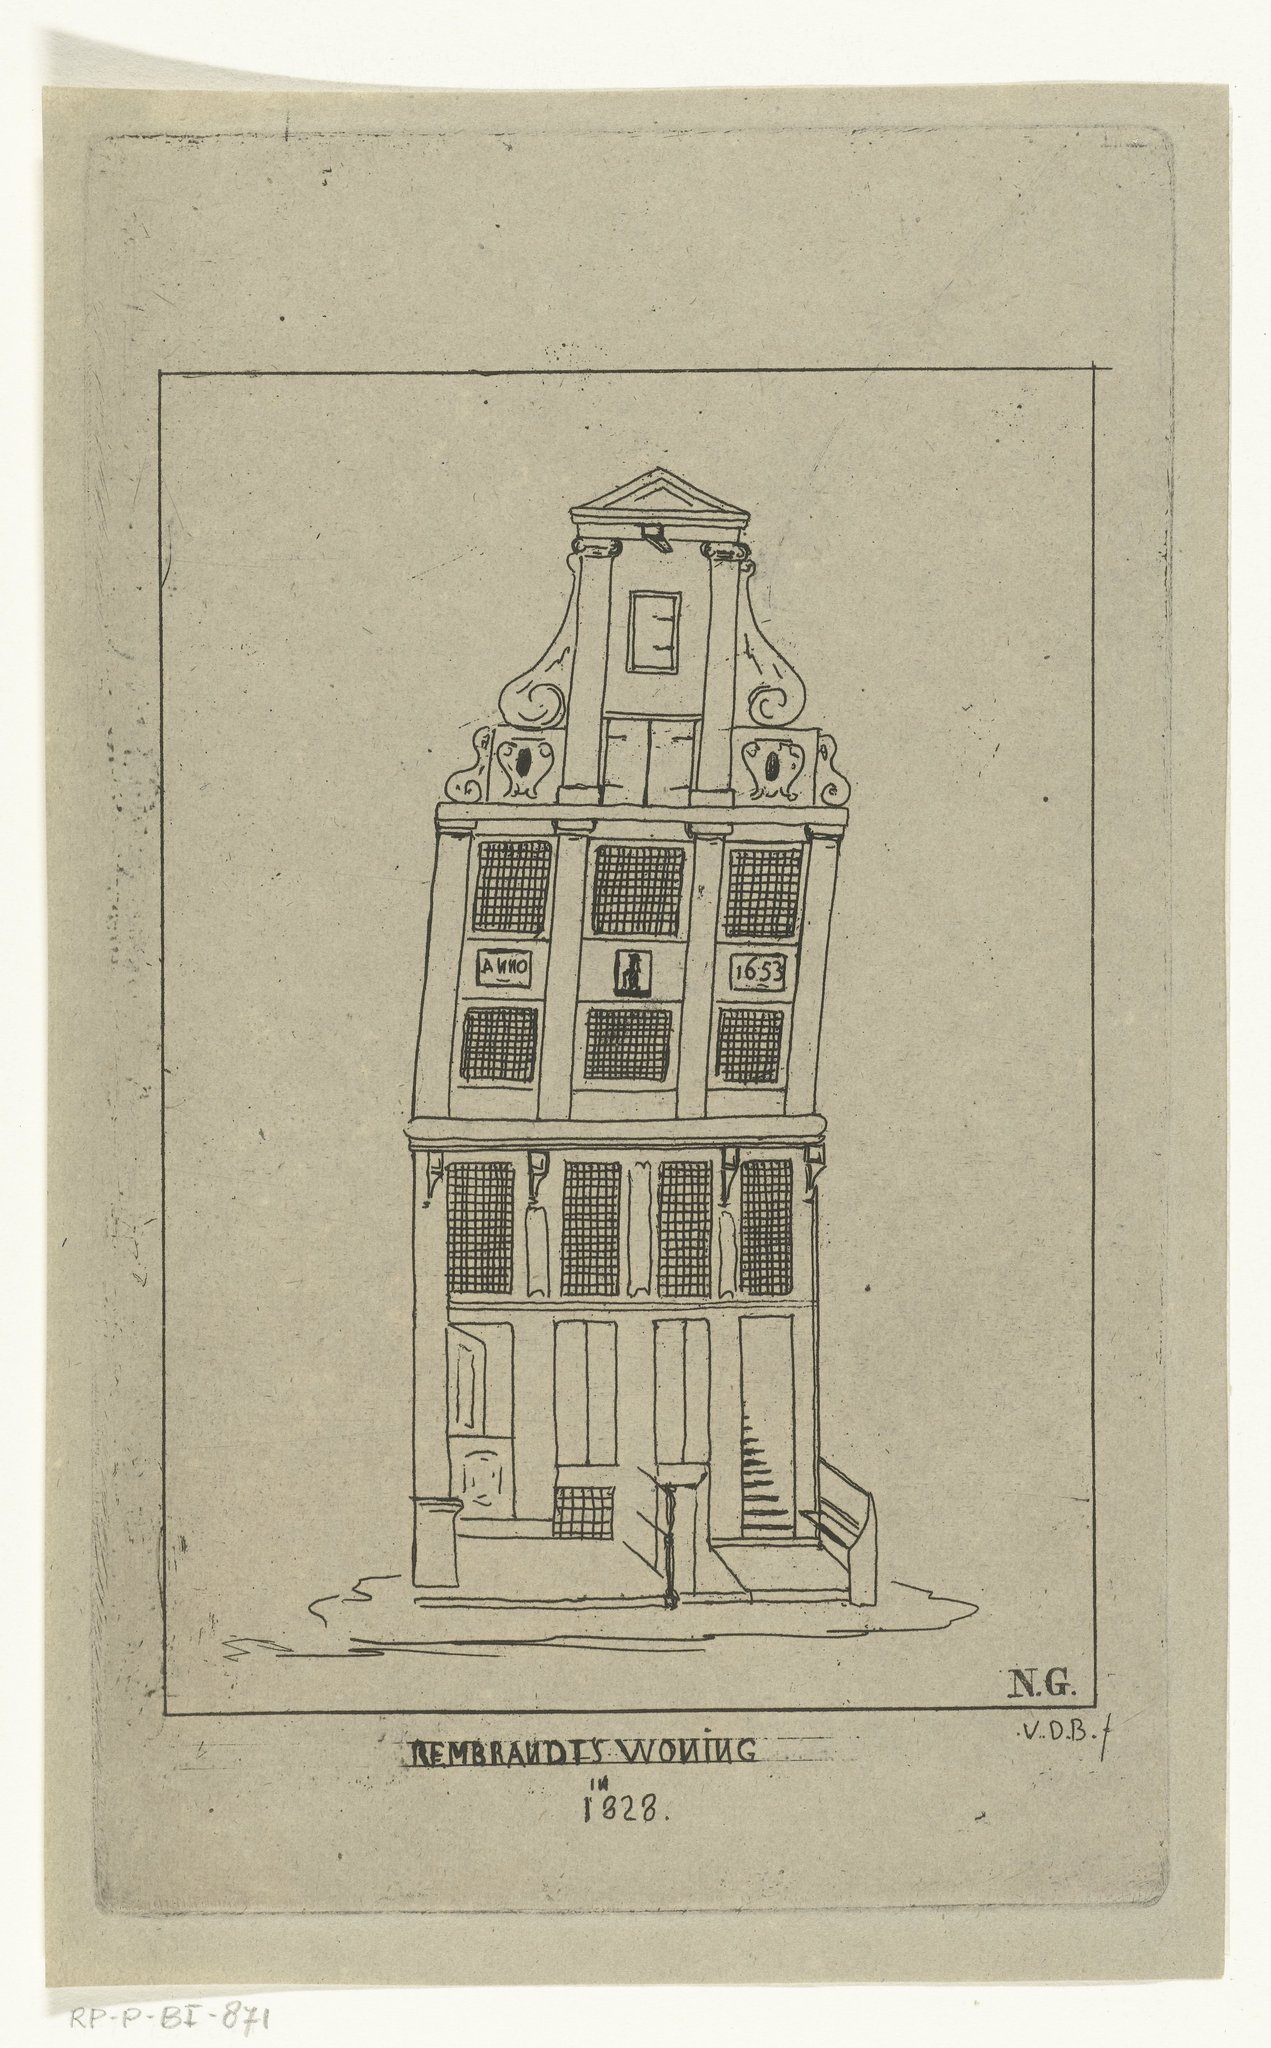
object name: print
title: Woonhuis van Rembrandt Harmenszn. van Rijn in 1828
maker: jonkheer isaac lambertus cremer van den berch van heemstede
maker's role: print maker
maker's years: 1811-1879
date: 1828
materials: paper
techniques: etching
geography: netherlands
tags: the usual house or row of houses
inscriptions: collector's mark: Lugt 2228, collector's mark: Lugt 1967